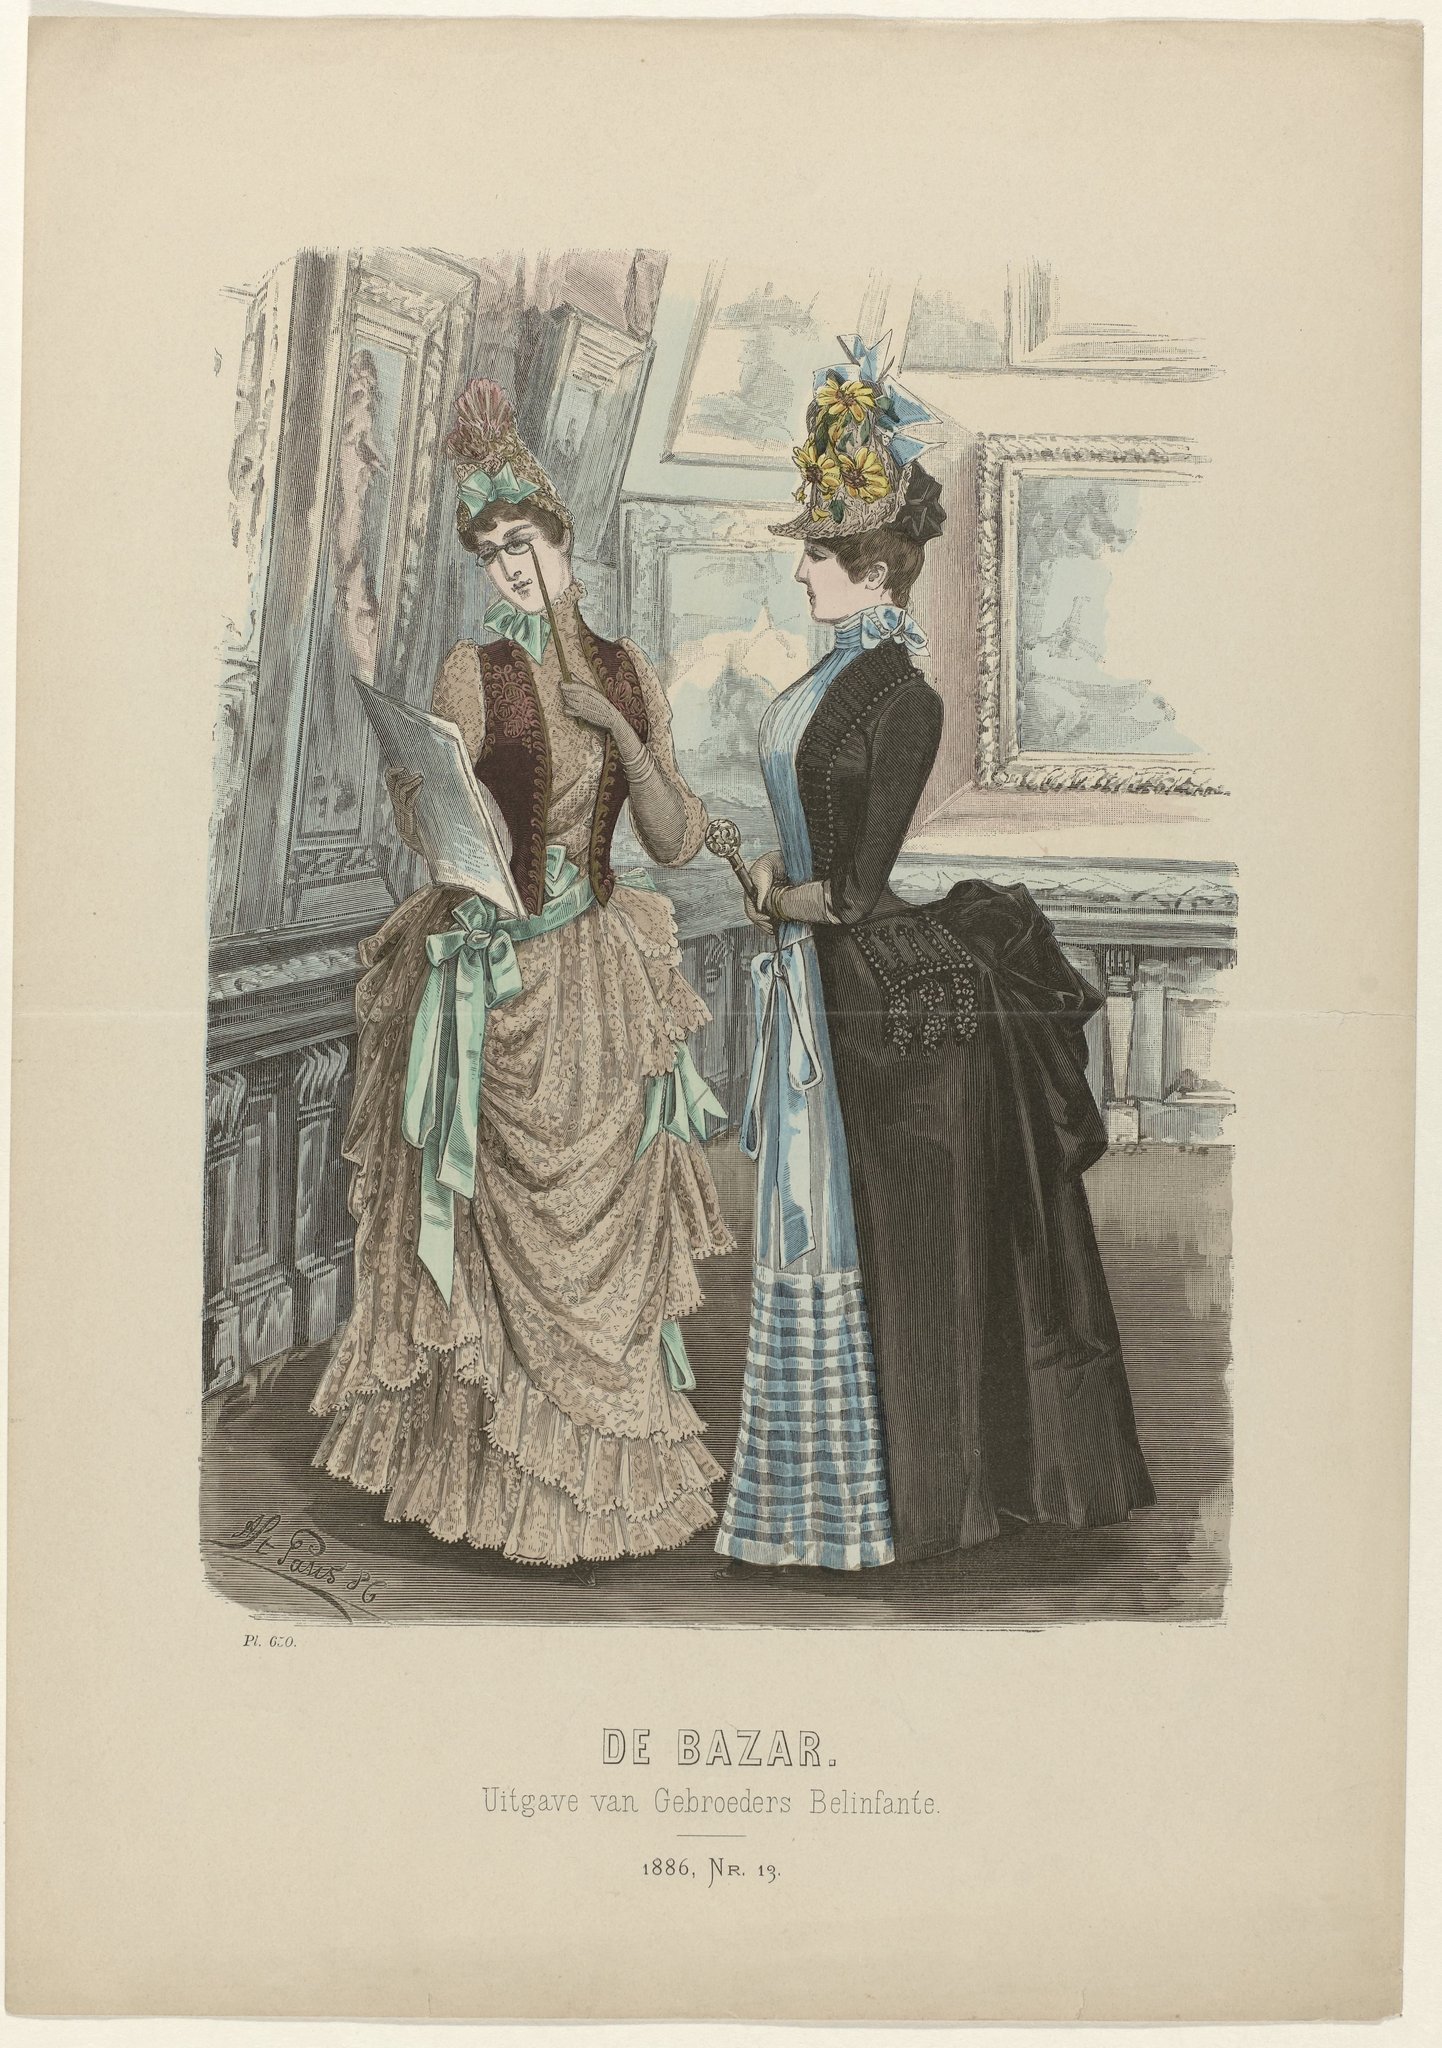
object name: fashion print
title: De Bazar, 1886, Nr. 13, Pl. 650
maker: Anonymous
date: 1886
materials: paper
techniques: hand coloring, engraving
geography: the hague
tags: fashion plates, dress, gown (+ women's clothes)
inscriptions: caption: ‘DE BAZAR. / Uitgave van Gebroeders Belinfante. / 1886, Nr. 13’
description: Twee dames op een schilderijententoonstelling. Prent uit het modetijdschrift De Bazar, geïllustreerd Tijdschrift voor Modes en Handwerken (1857-1900).